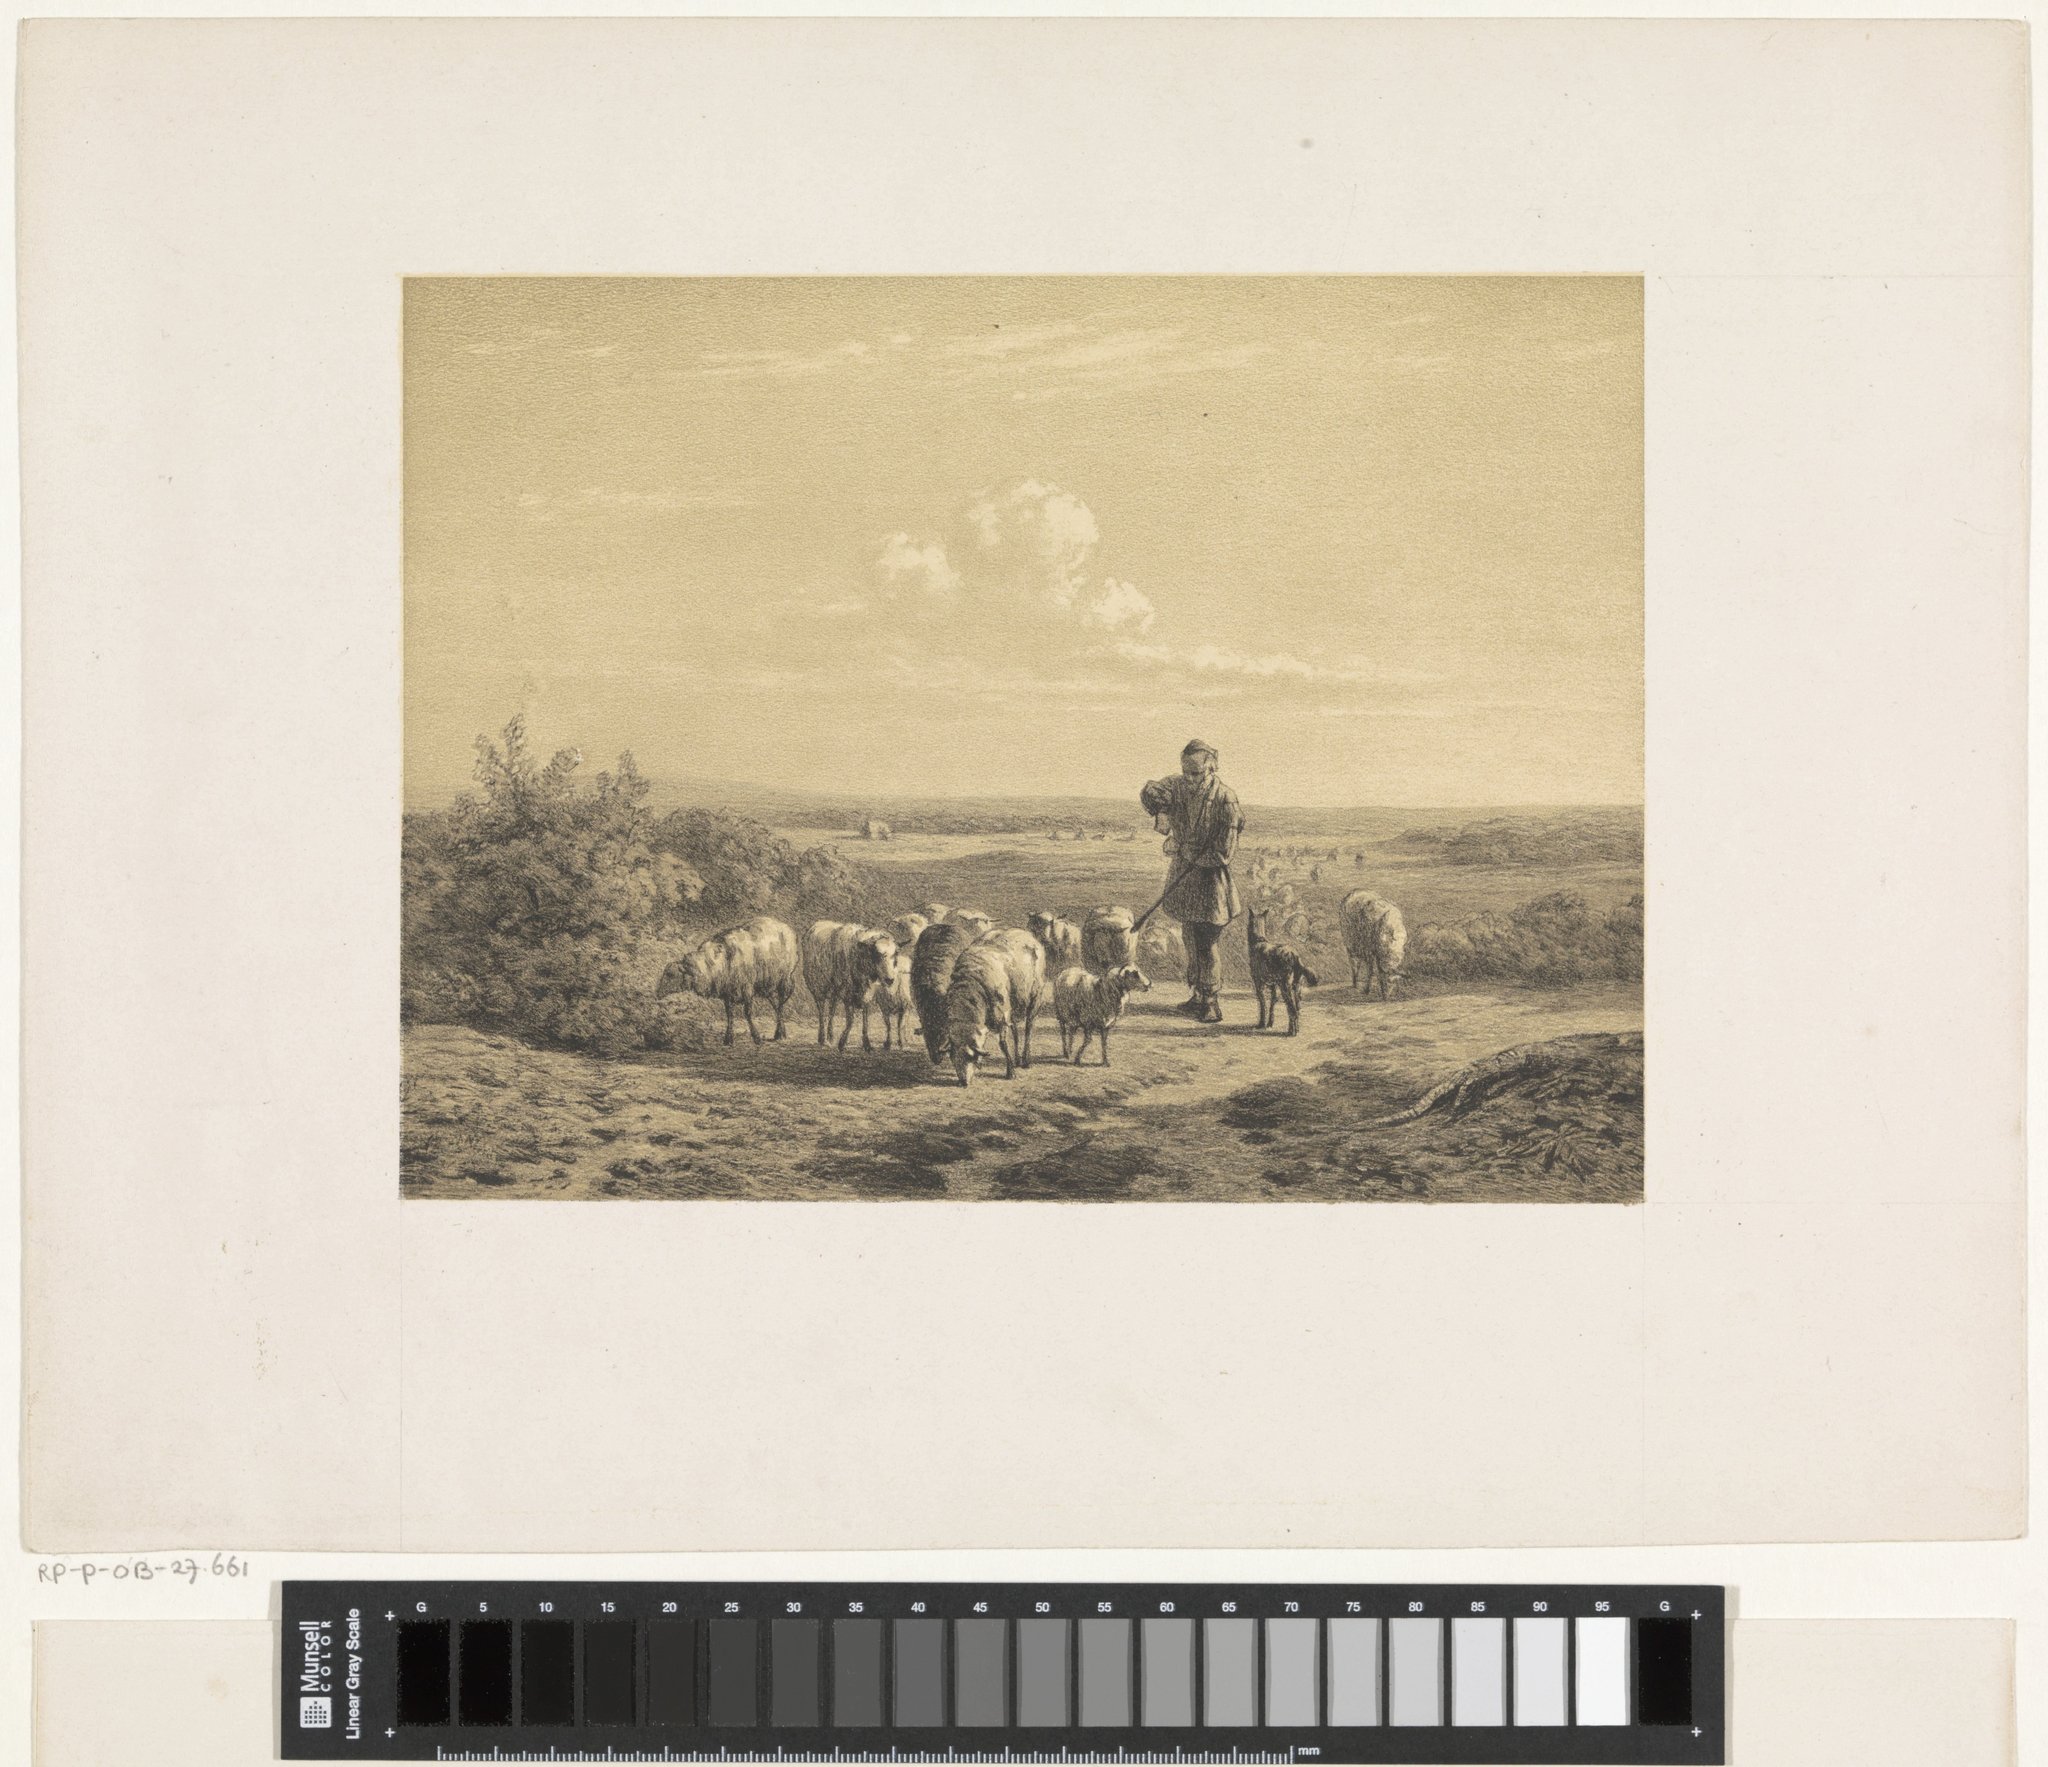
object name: print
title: Herder met zijn schapen op de hei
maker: simon van den berg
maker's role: draughtsman, print maker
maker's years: 1812-1891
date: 1822-1891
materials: paper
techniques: tone lithography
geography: netherlands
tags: herding, herdsman, herdswoman, shepherd, shepherdess, cowherd, etc., meadow, pasture, sheep, dog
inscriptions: collector's mark: Lugt 2228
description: Deze staat bevat niet de namen van de prentmaker en drukker, maar wel de kleur van het toonblok.